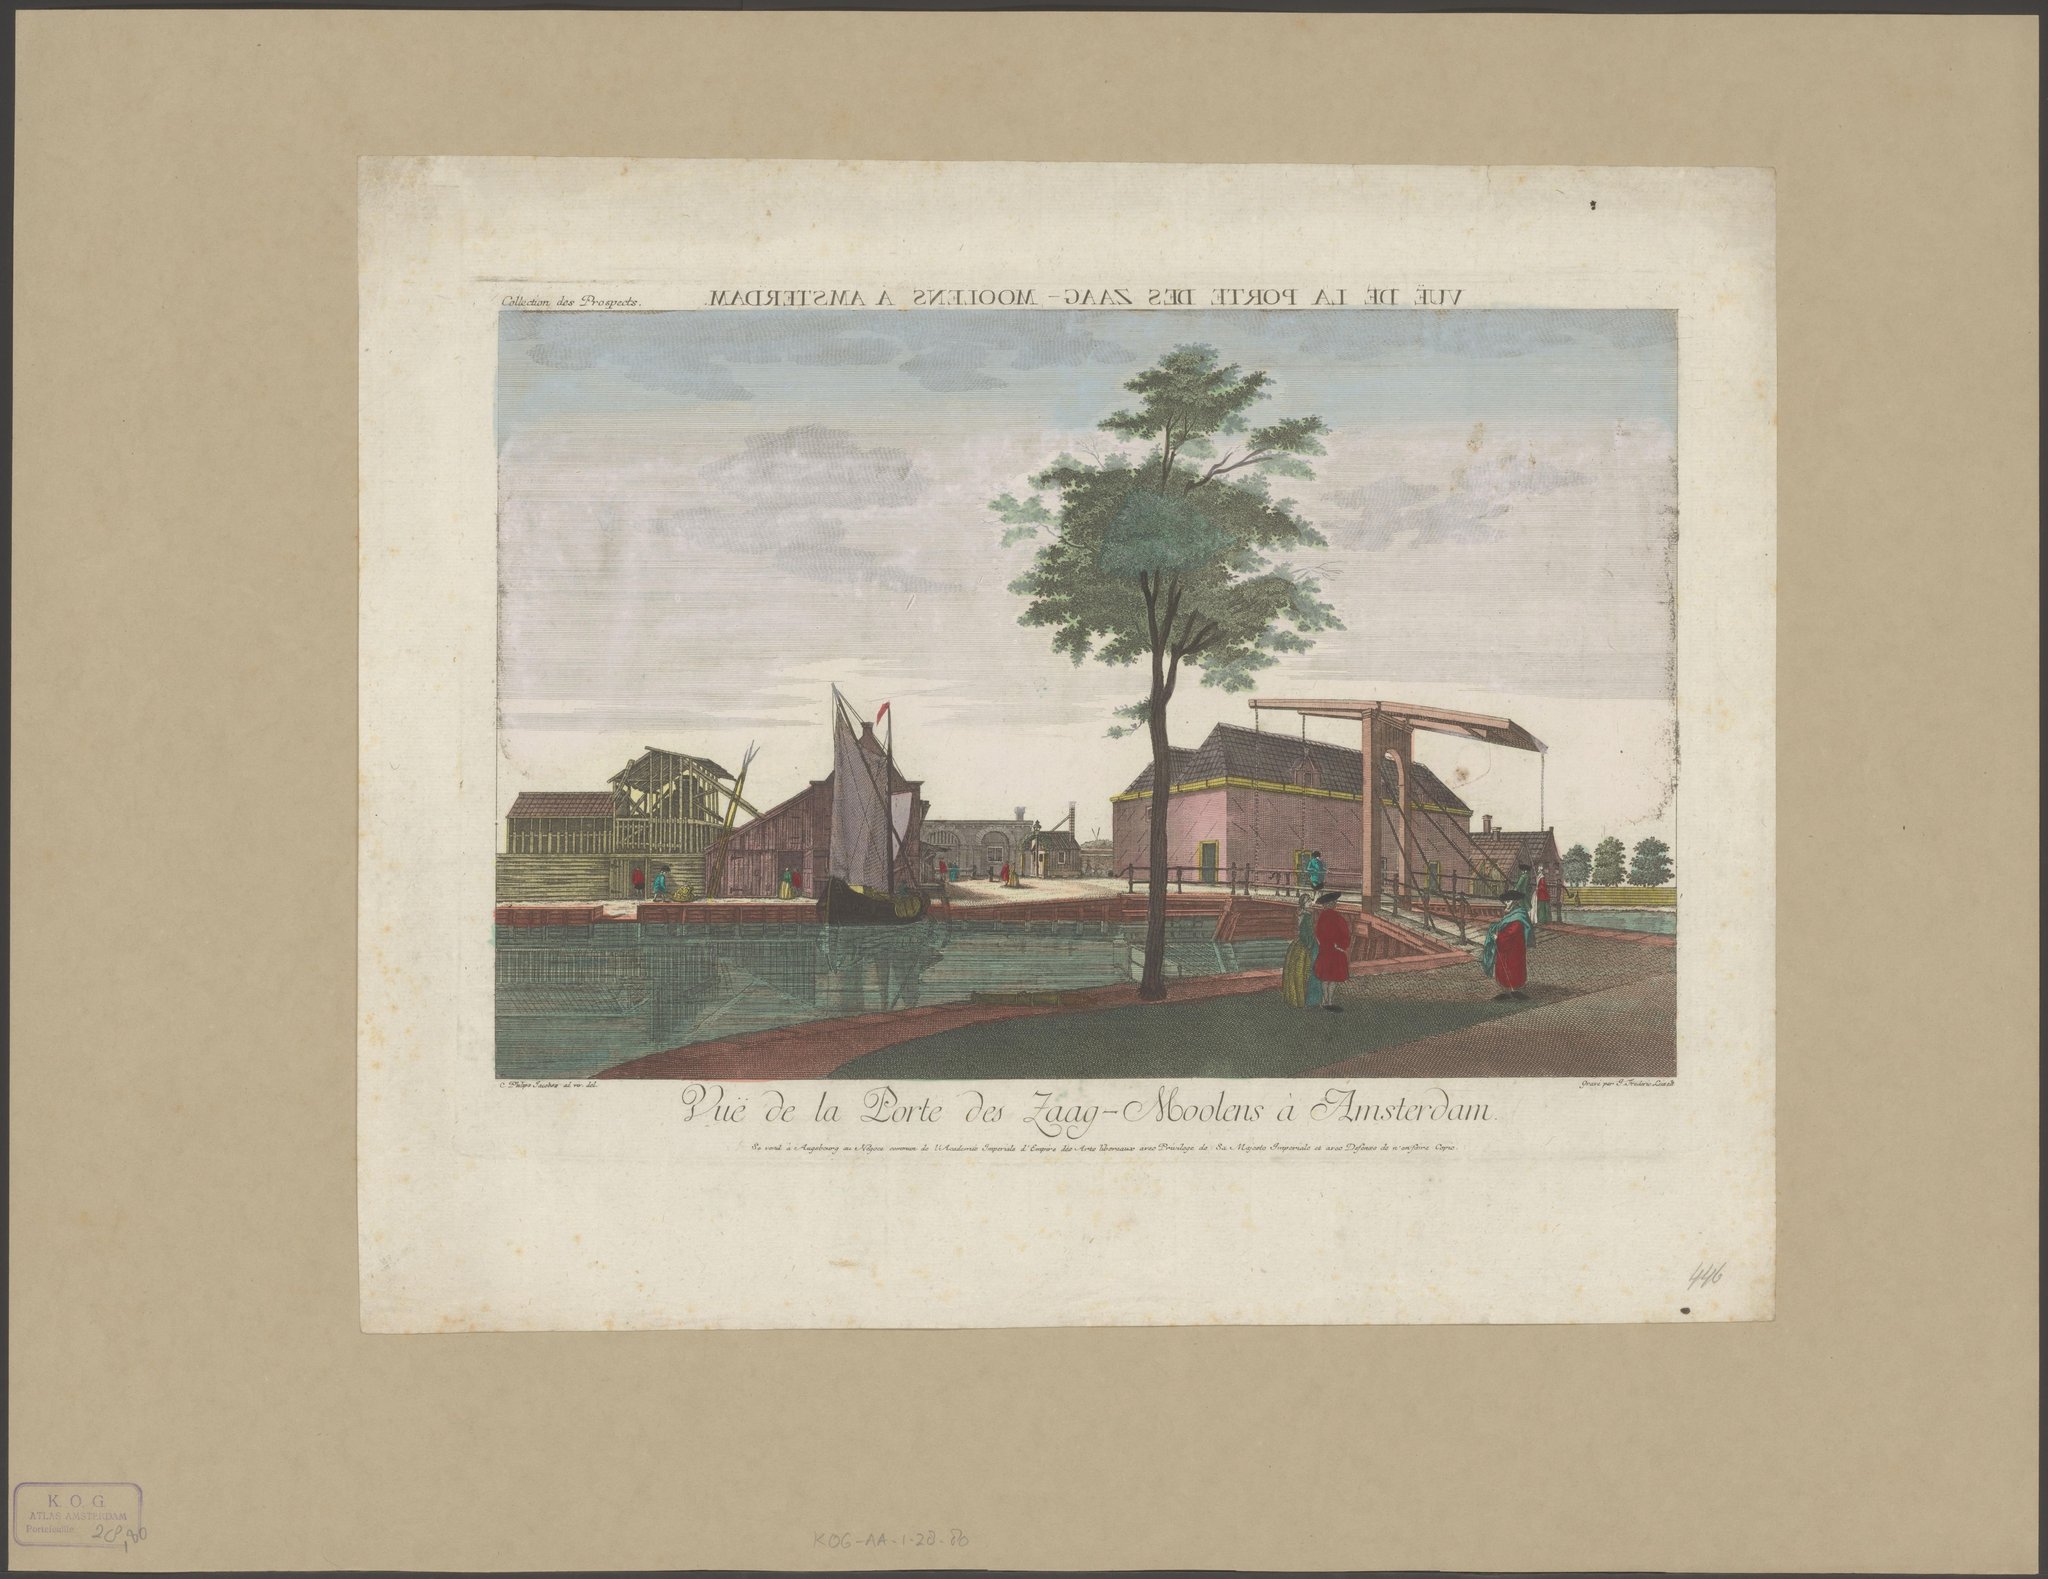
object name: opticaprent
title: Gezicht op de Zaagmolenpoort te Amsterdam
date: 1755-1779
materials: paper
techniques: engraving, etching, hand coloring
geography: amsterdam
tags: bridge in city across river, canal, etc. (+ city(-scape) with figures, staffage), sailing-ship, sailing-boat, city-gate, street (+ city(-scape) with figures, staffage)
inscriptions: collector's mark: Lugt 1641b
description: Onderwerpsrubriek binnen de Atlas Amsterdam: Zaagmolenpoort.